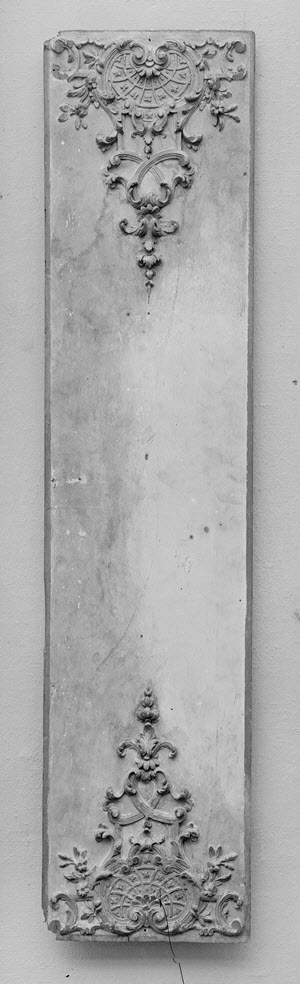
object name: panel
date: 1701-1733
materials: wood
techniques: gilding, painting